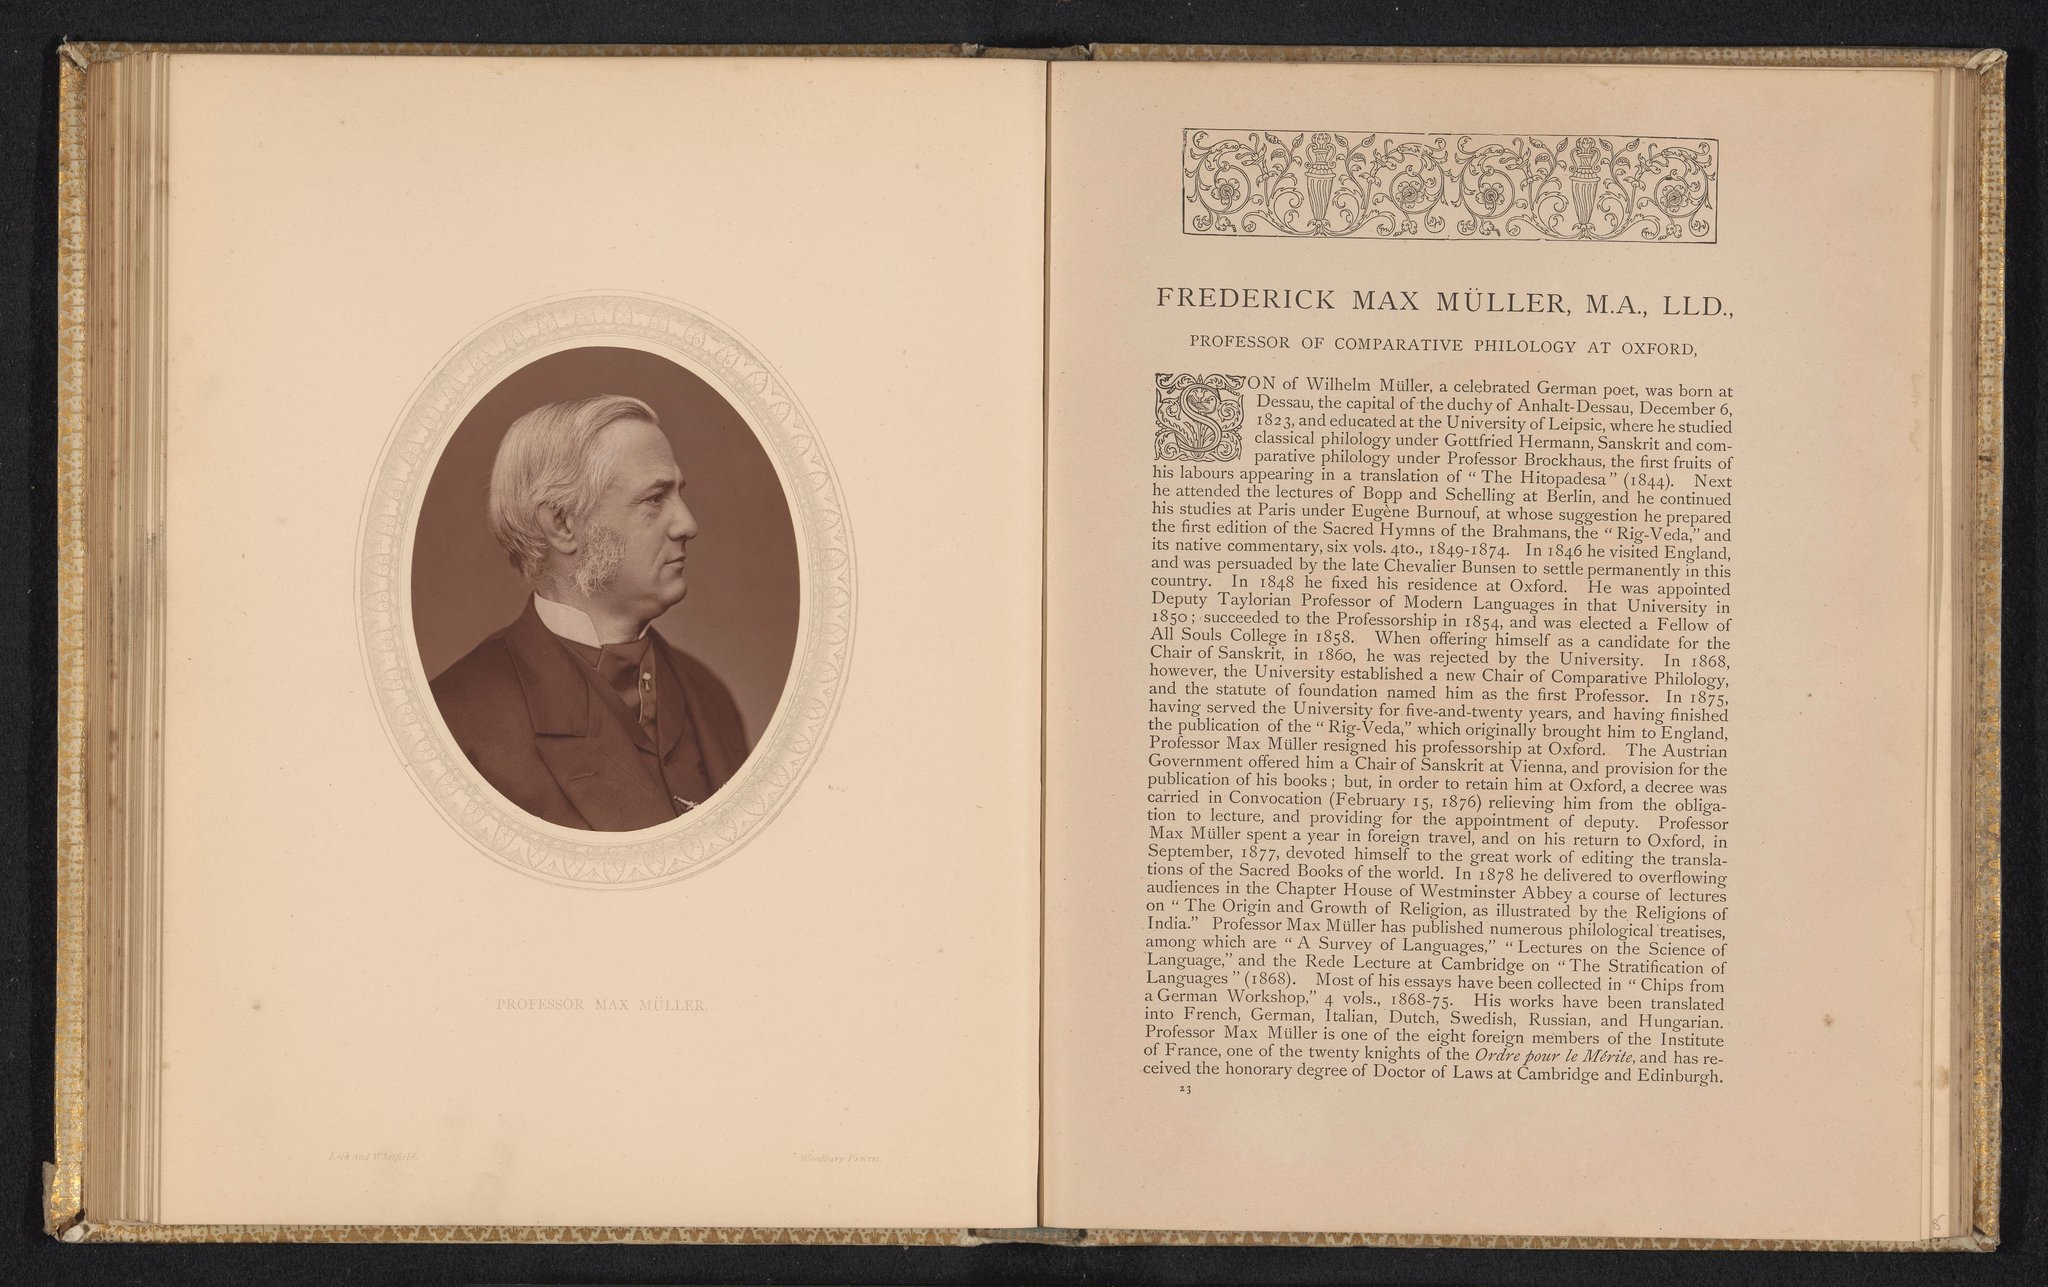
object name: photomechanical print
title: Professor Max Müller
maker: Anonymous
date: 1873-1878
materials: paper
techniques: woodburytype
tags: scholar, philosopher, historical persons (portraits and scenes from the life) (+ (full) bust portrait)